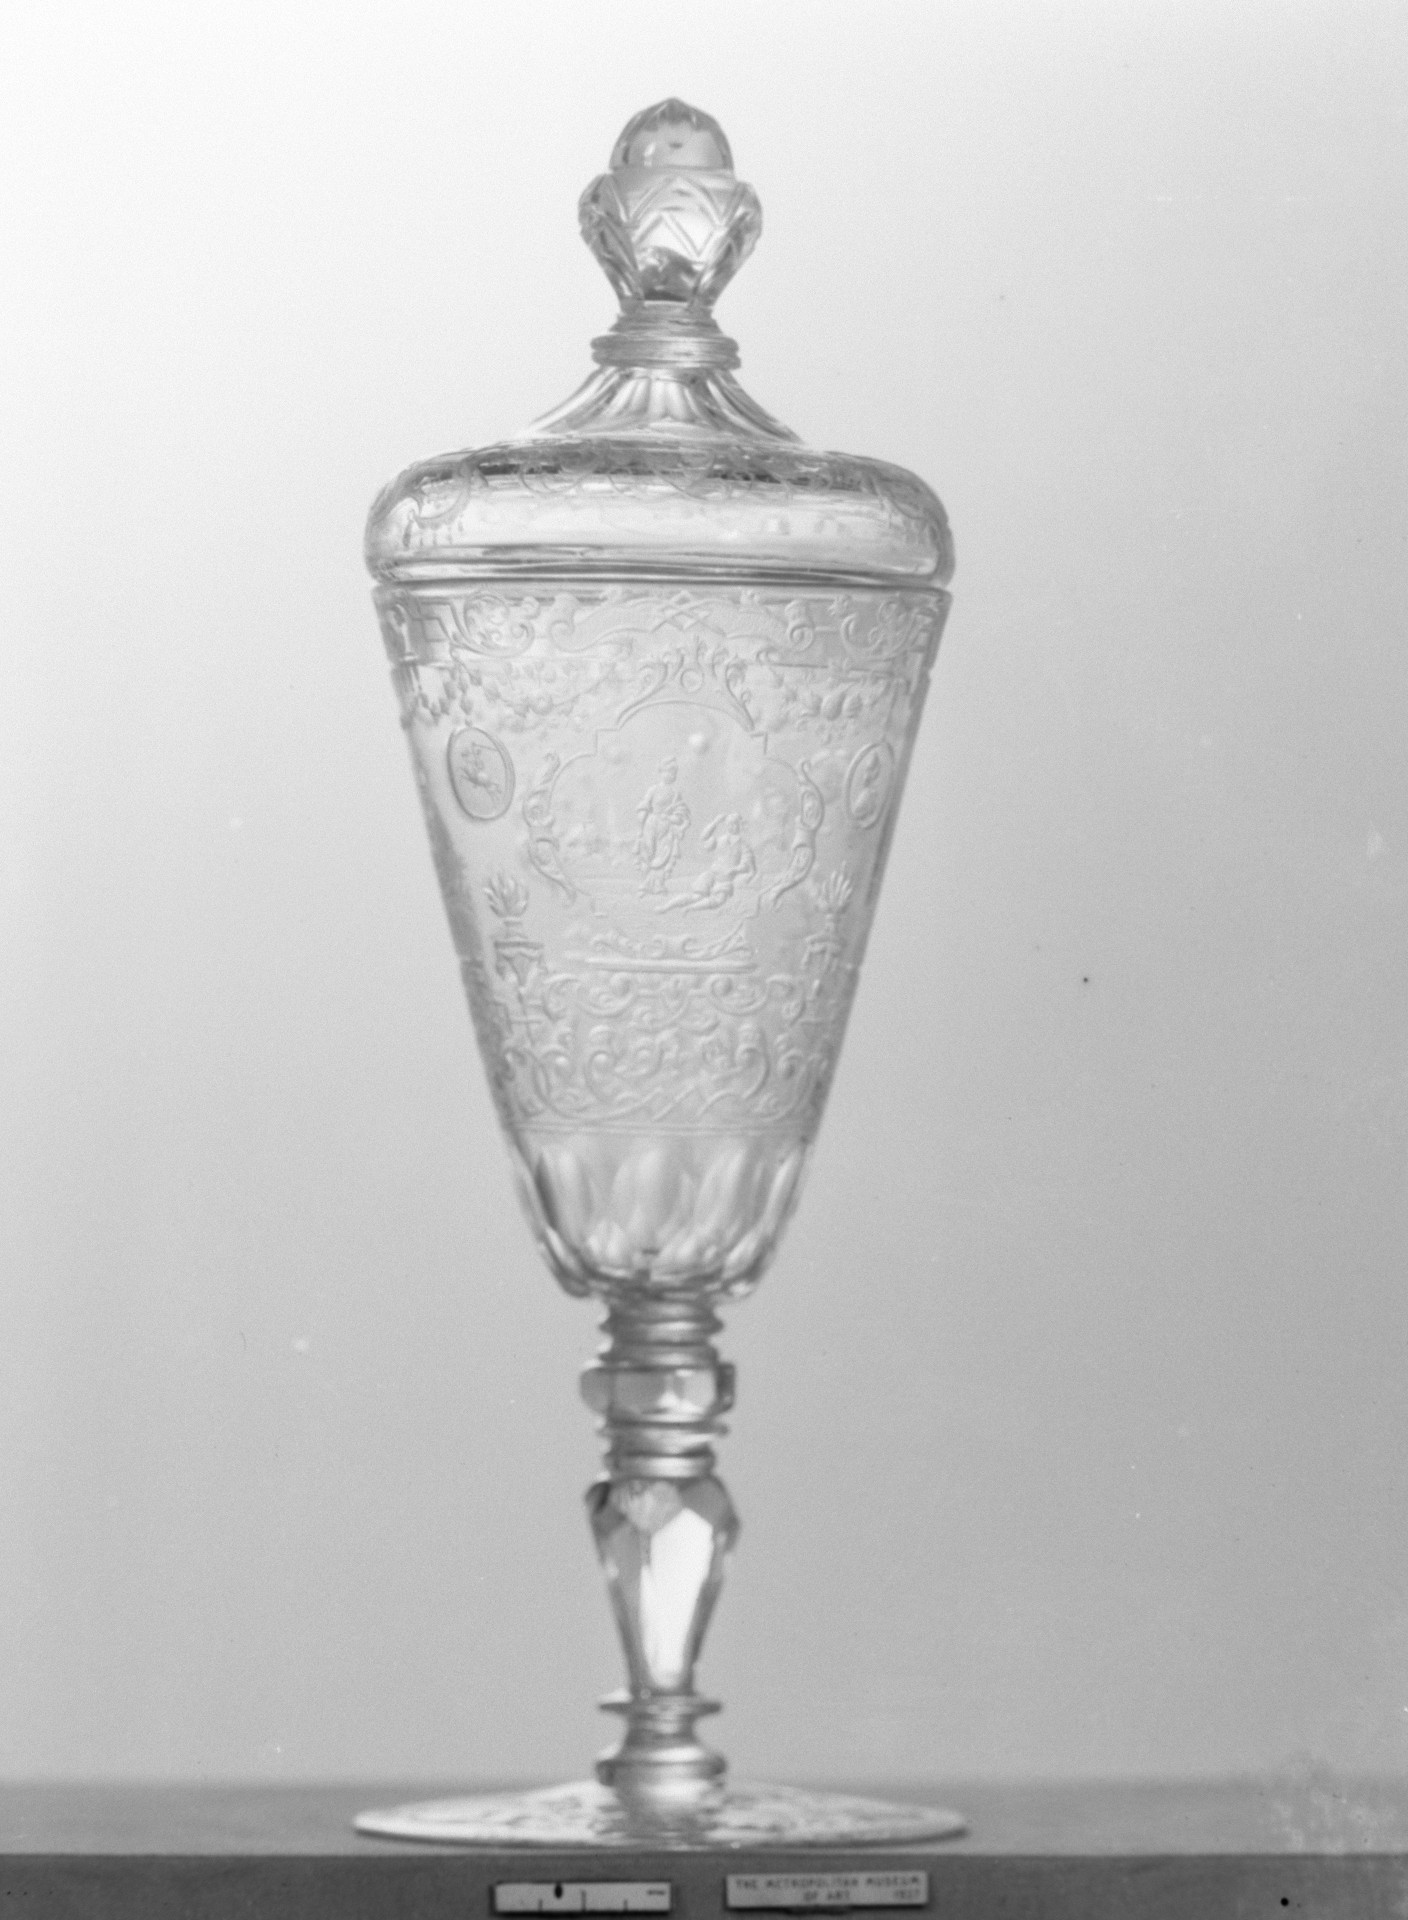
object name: standing cup with cover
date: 1701-1733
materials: glass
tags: men,women